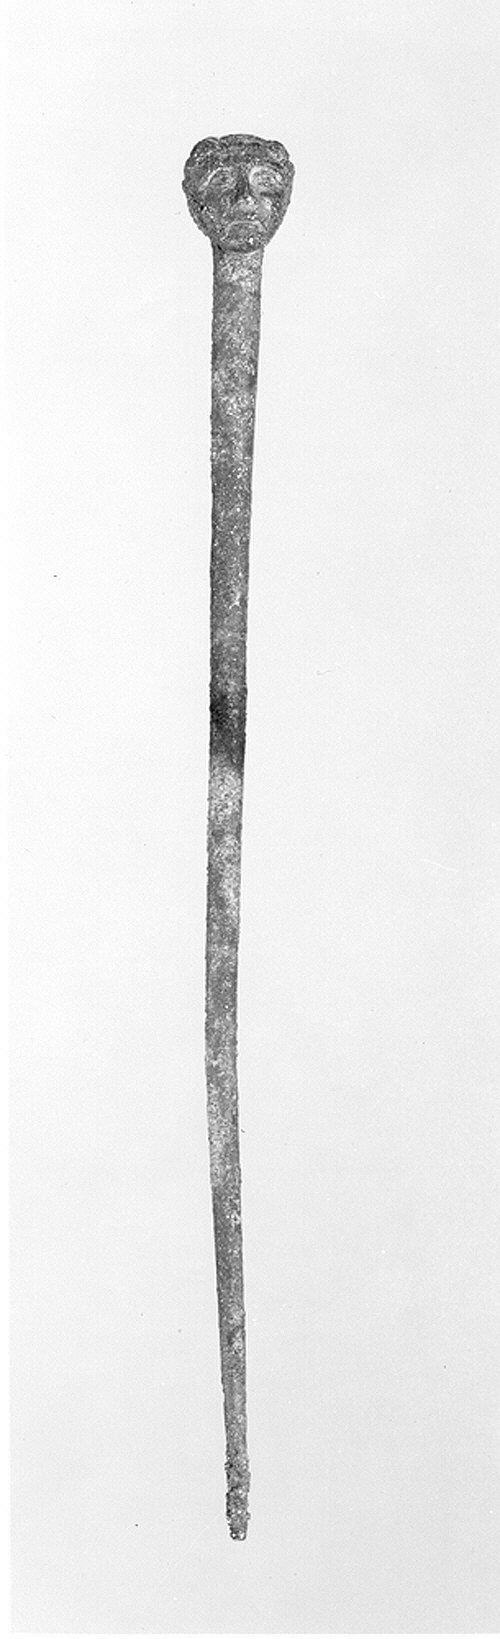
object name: pin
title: Pin terminating in a male head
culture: parthian or kushan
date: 1-100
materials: silver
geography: indus region or eastern iran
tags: heads,men